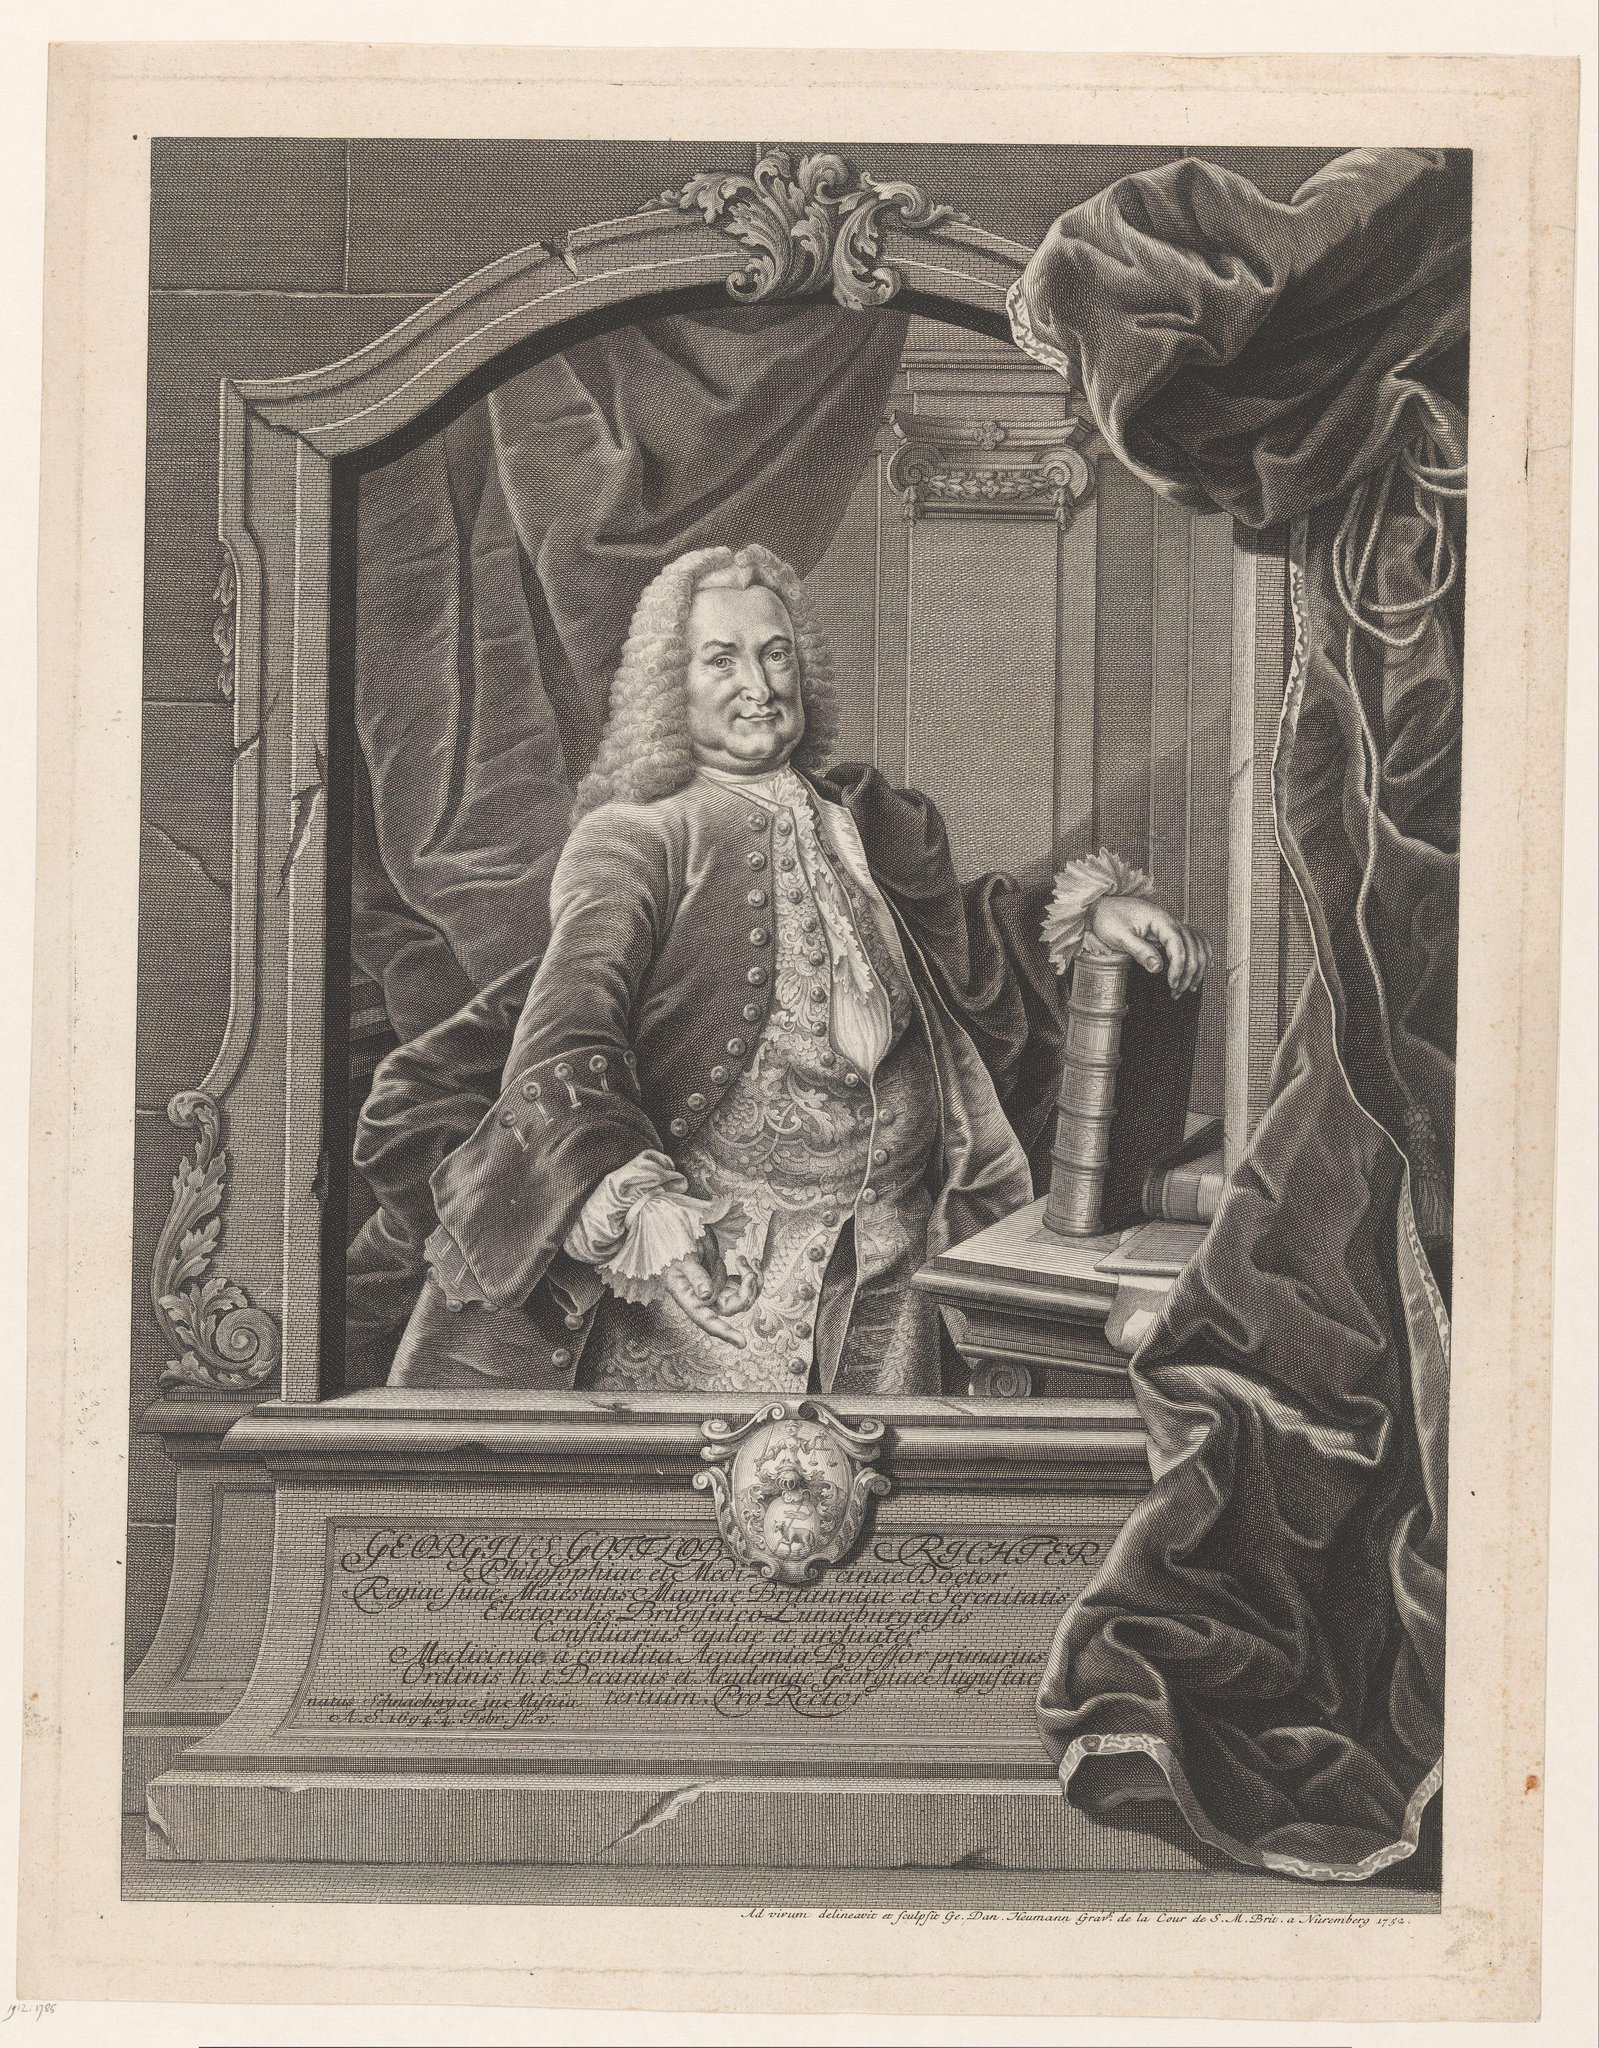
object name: print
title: Portret van Georg Gottlob Richter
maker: georg daniel heumann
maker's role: print maker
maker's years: 1691-1759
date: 1752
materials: paper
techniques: engraving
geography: nuremberg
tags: historical persons, armorial bearing, heraldry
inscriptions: collector's mark: Lugt 2228